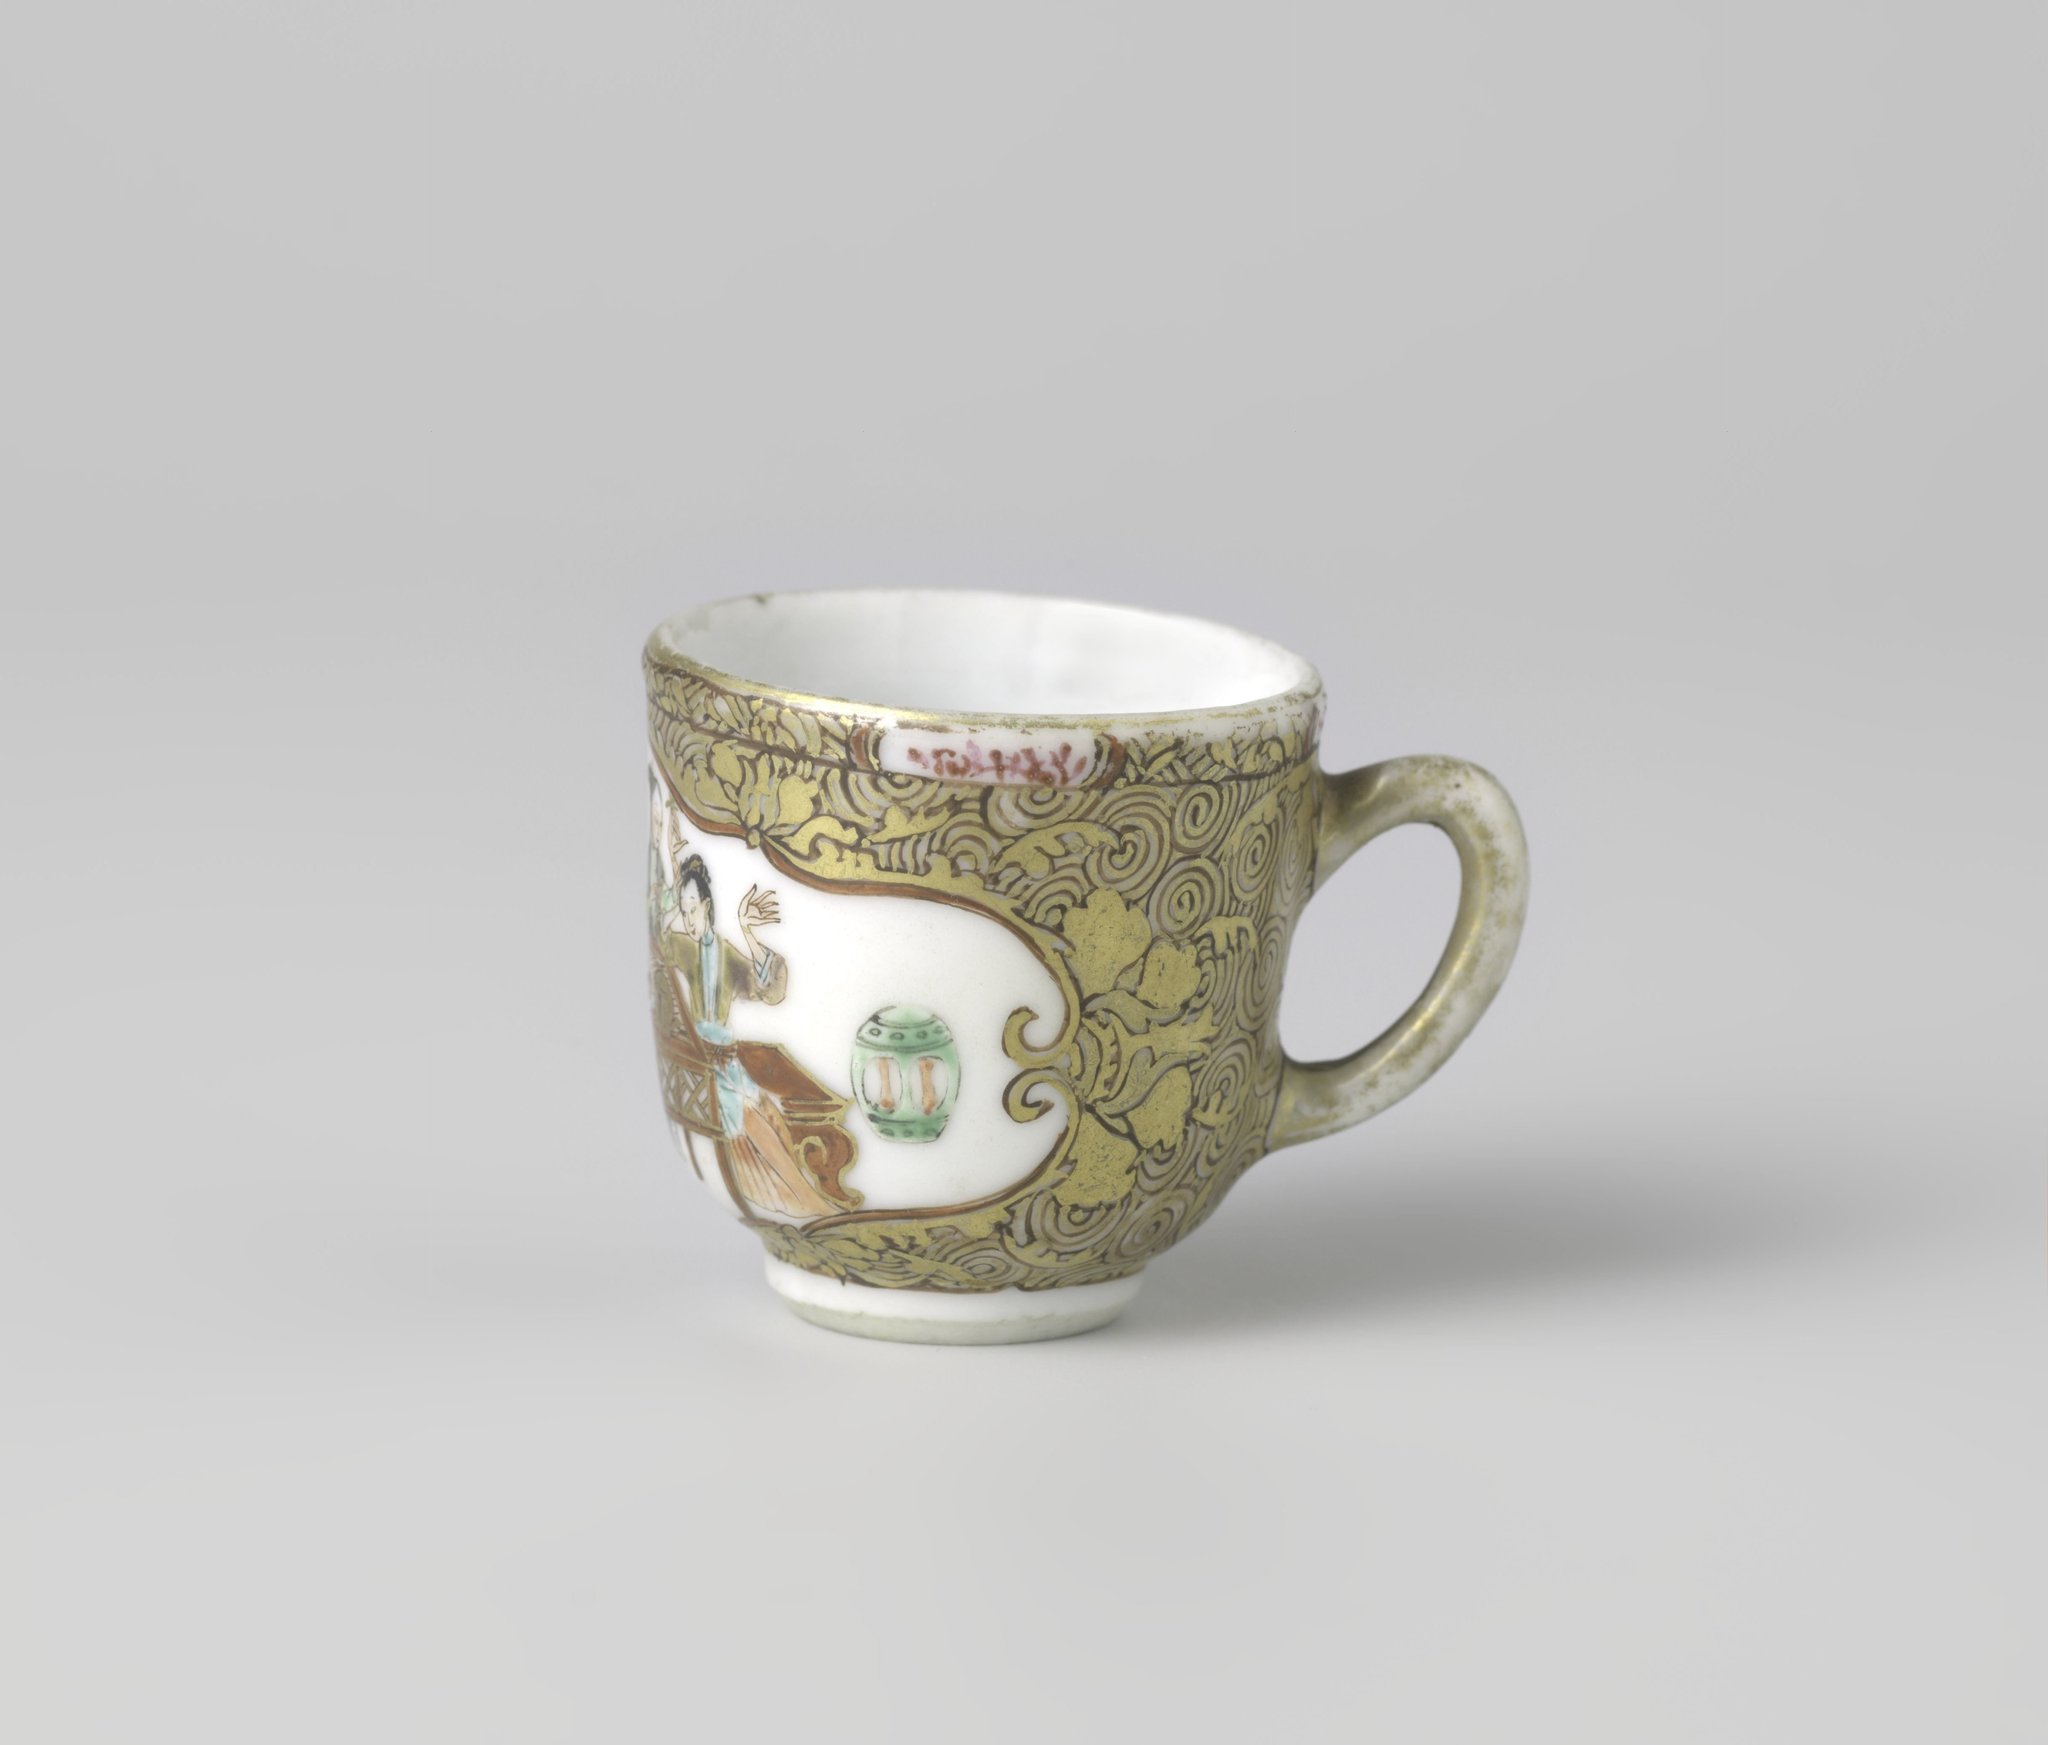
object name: oorkop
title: Cup with handle with three women in a panel on a ground of scrolls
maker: Anonymous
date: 1750-1774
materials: glaze, gold, paint, porcelain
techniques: firing, gilding, turning, vitrification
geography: china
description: Kleine oorkop van porselein, beschilderd op het glazuur in blauw, rood, roze, groen, geel, zwart en goud. De wand is bedekt met krulwerk en ranken met hierin uitgespaard een cartouche met drie vrouwen om een tafel met naast hen vazen en gelukssymbolen; op de bodem een twijg. Famille rose.